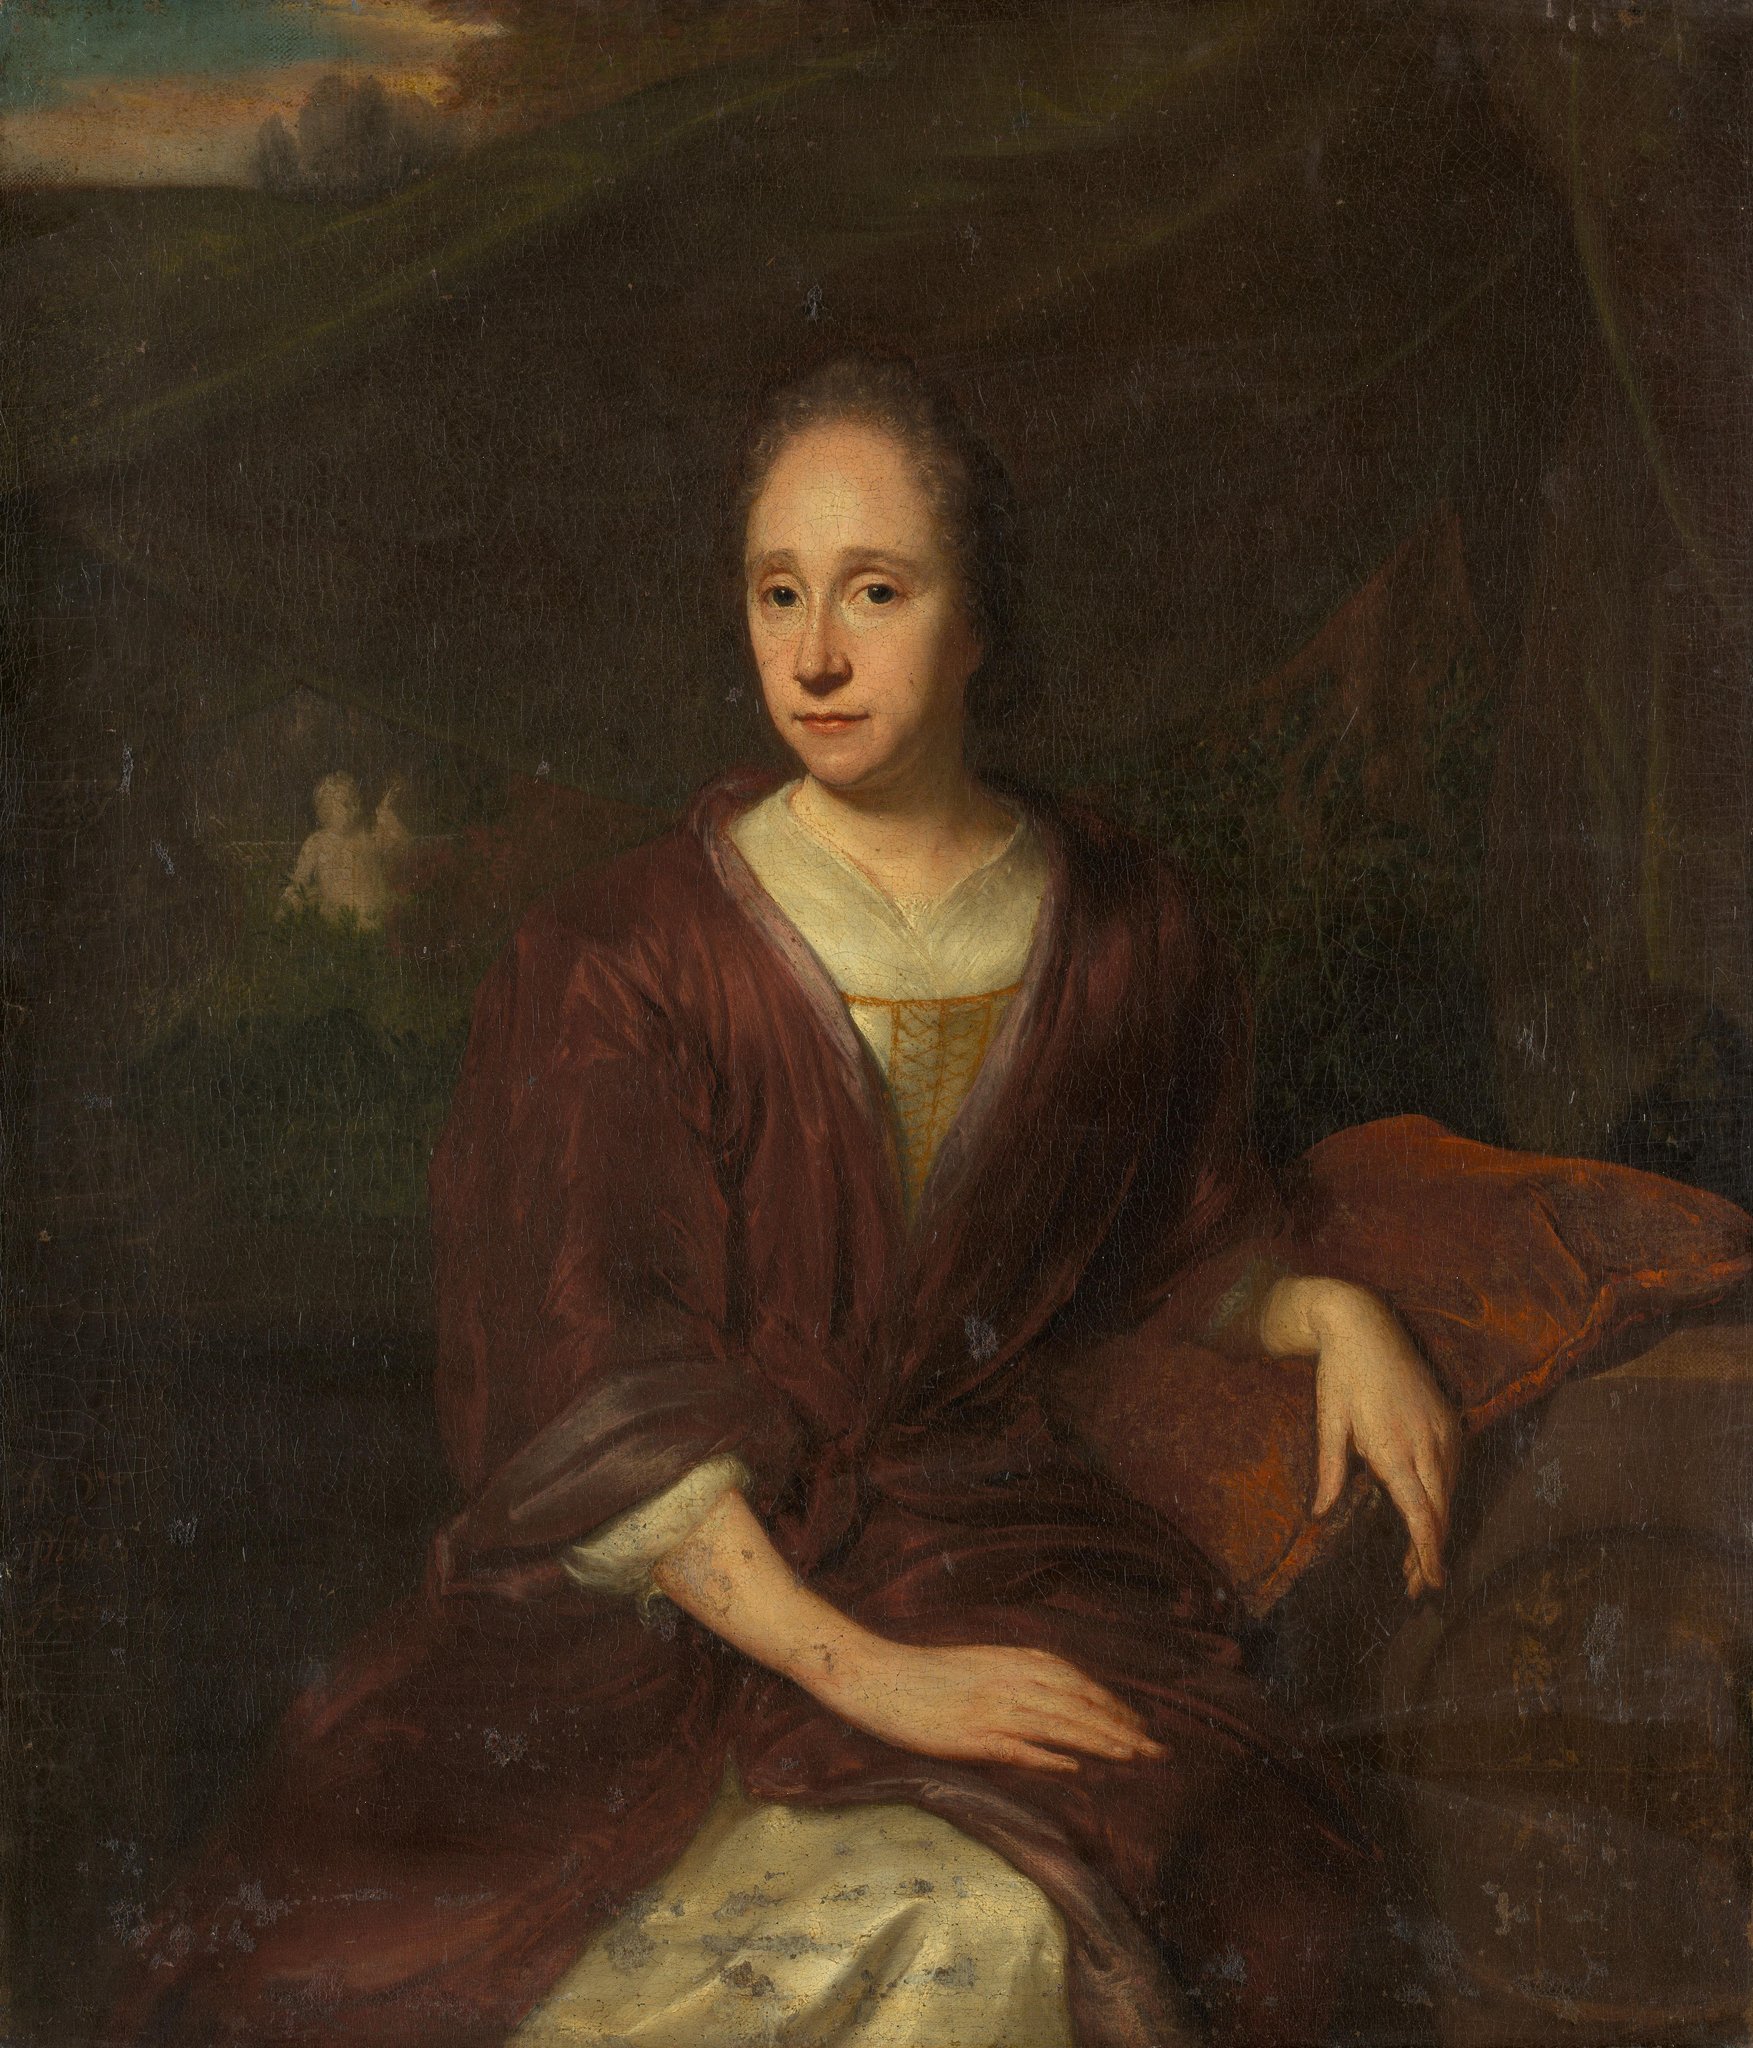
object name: painting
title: Portrait of Margaretha Nelis (1652-17050, second wife of Casparus Commelin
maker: david van der plas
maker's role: draughtsman, painter, print maker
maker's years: 1647-1704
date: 1693-1704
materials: canvas, oil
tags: historical persons - bb - woman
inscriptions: signature: ‘D. Vr. Plaes fecit’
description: Portret van Margaretha Nelis (1652-1705), de tweede echtgenote van Casparus Commelin. Kniestuk, zittende geleund tegen een kussen. Links op de achtergrond een beeldje. Pendant van SK-C-517.